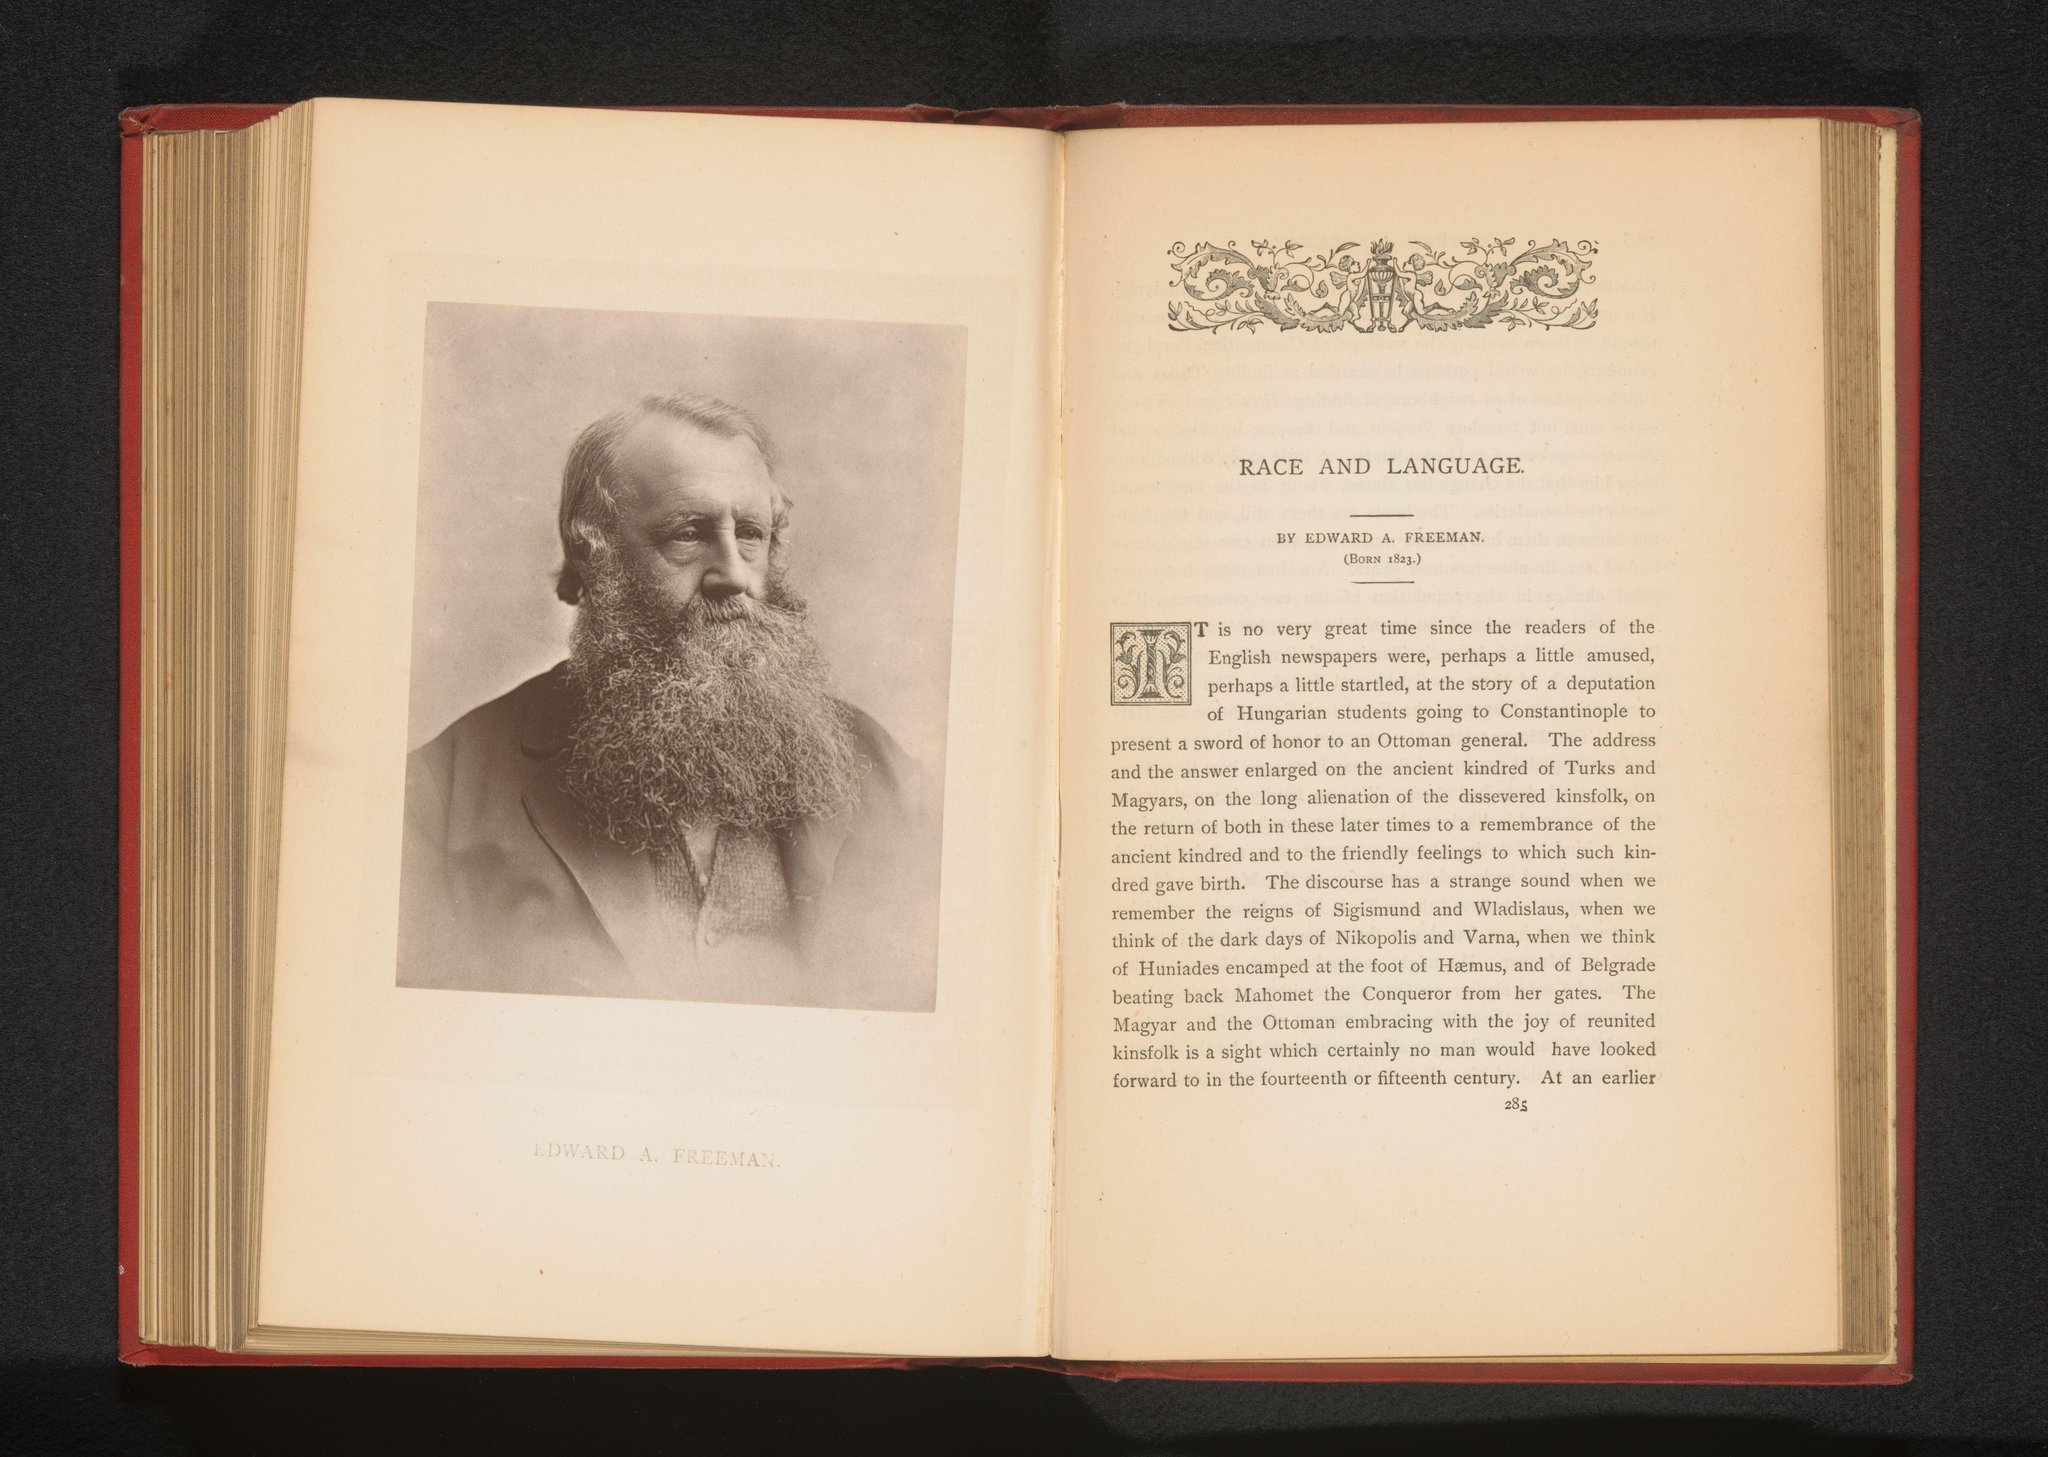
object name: photomechanical print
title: Edward A. Freeman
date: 1881-1886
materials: paper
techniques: woodburytype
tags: adult man, historical persons